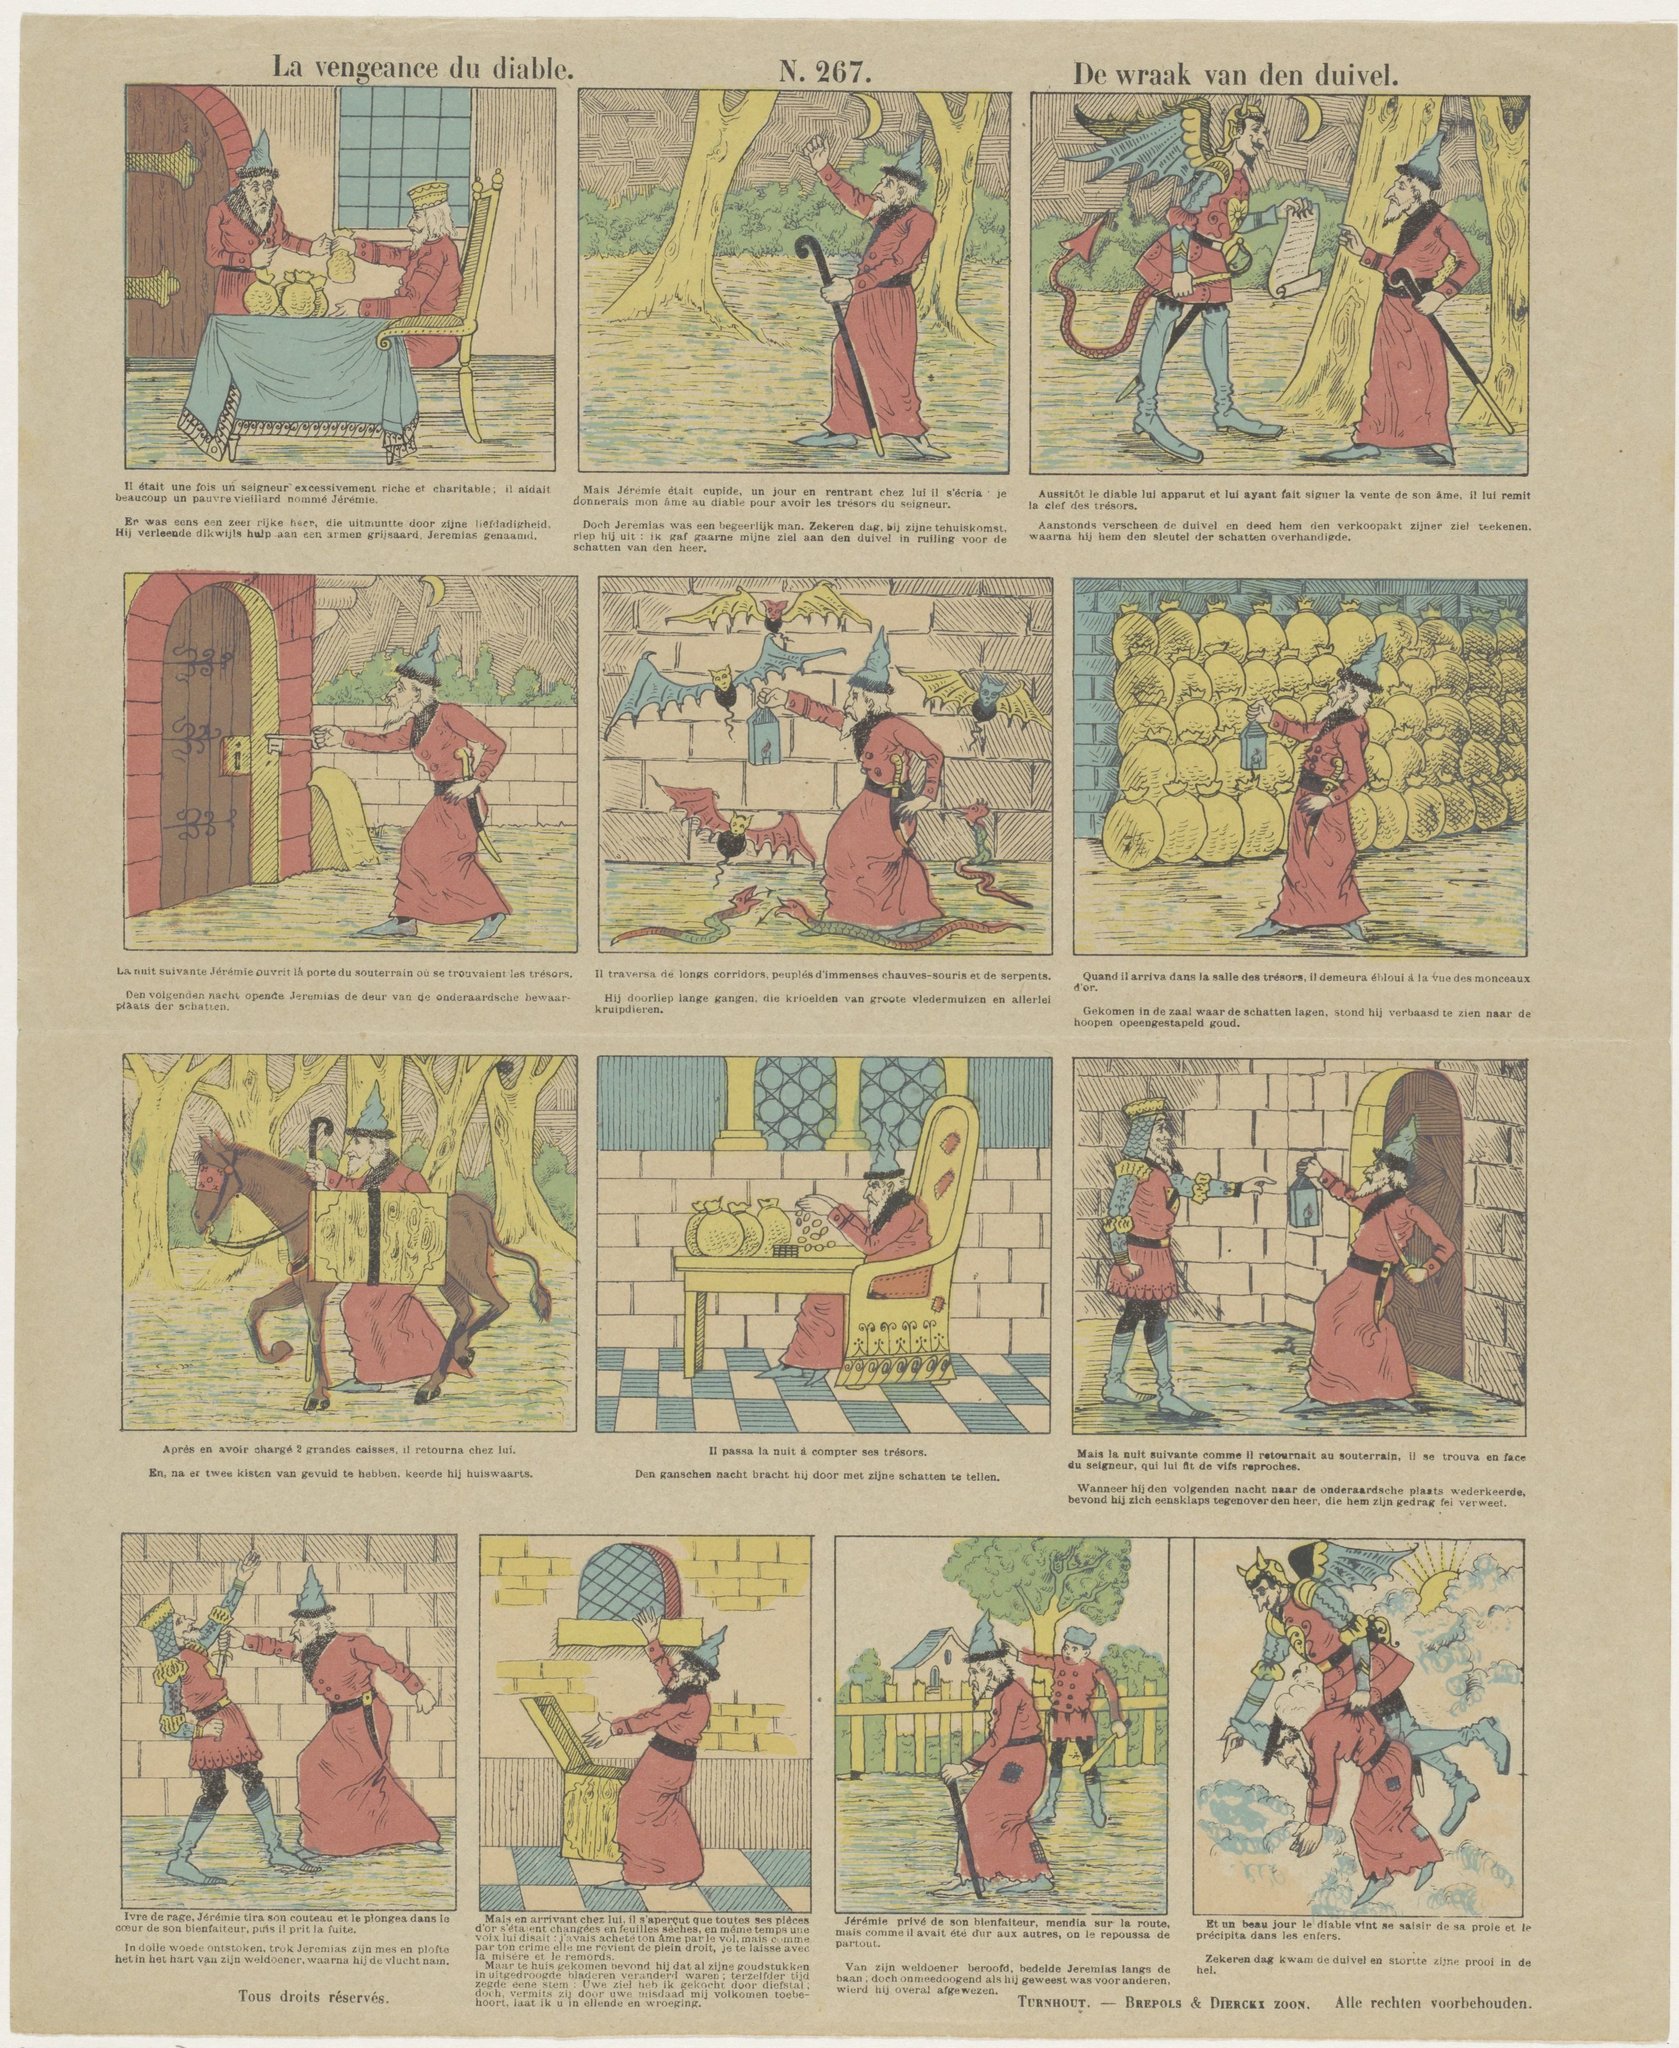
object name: popular print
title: La vegeance du diable / De wraak van den duivel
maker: Anonymous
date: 1833-1911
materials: paper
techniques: lithograph, letterpress printing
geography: turnhout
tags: pact with the devil, selling one's soul to the devil, tales and fairy tales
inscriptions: octrooivermelding, gedrukt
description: Blad met 13 voorstellingen over de oude jeremias die zijn ziel aan de duivel verkoopt. Onder elke afbeelding een onderschrift in het Nederlands en in het Frans. Genummerd midden boven: N. 267.